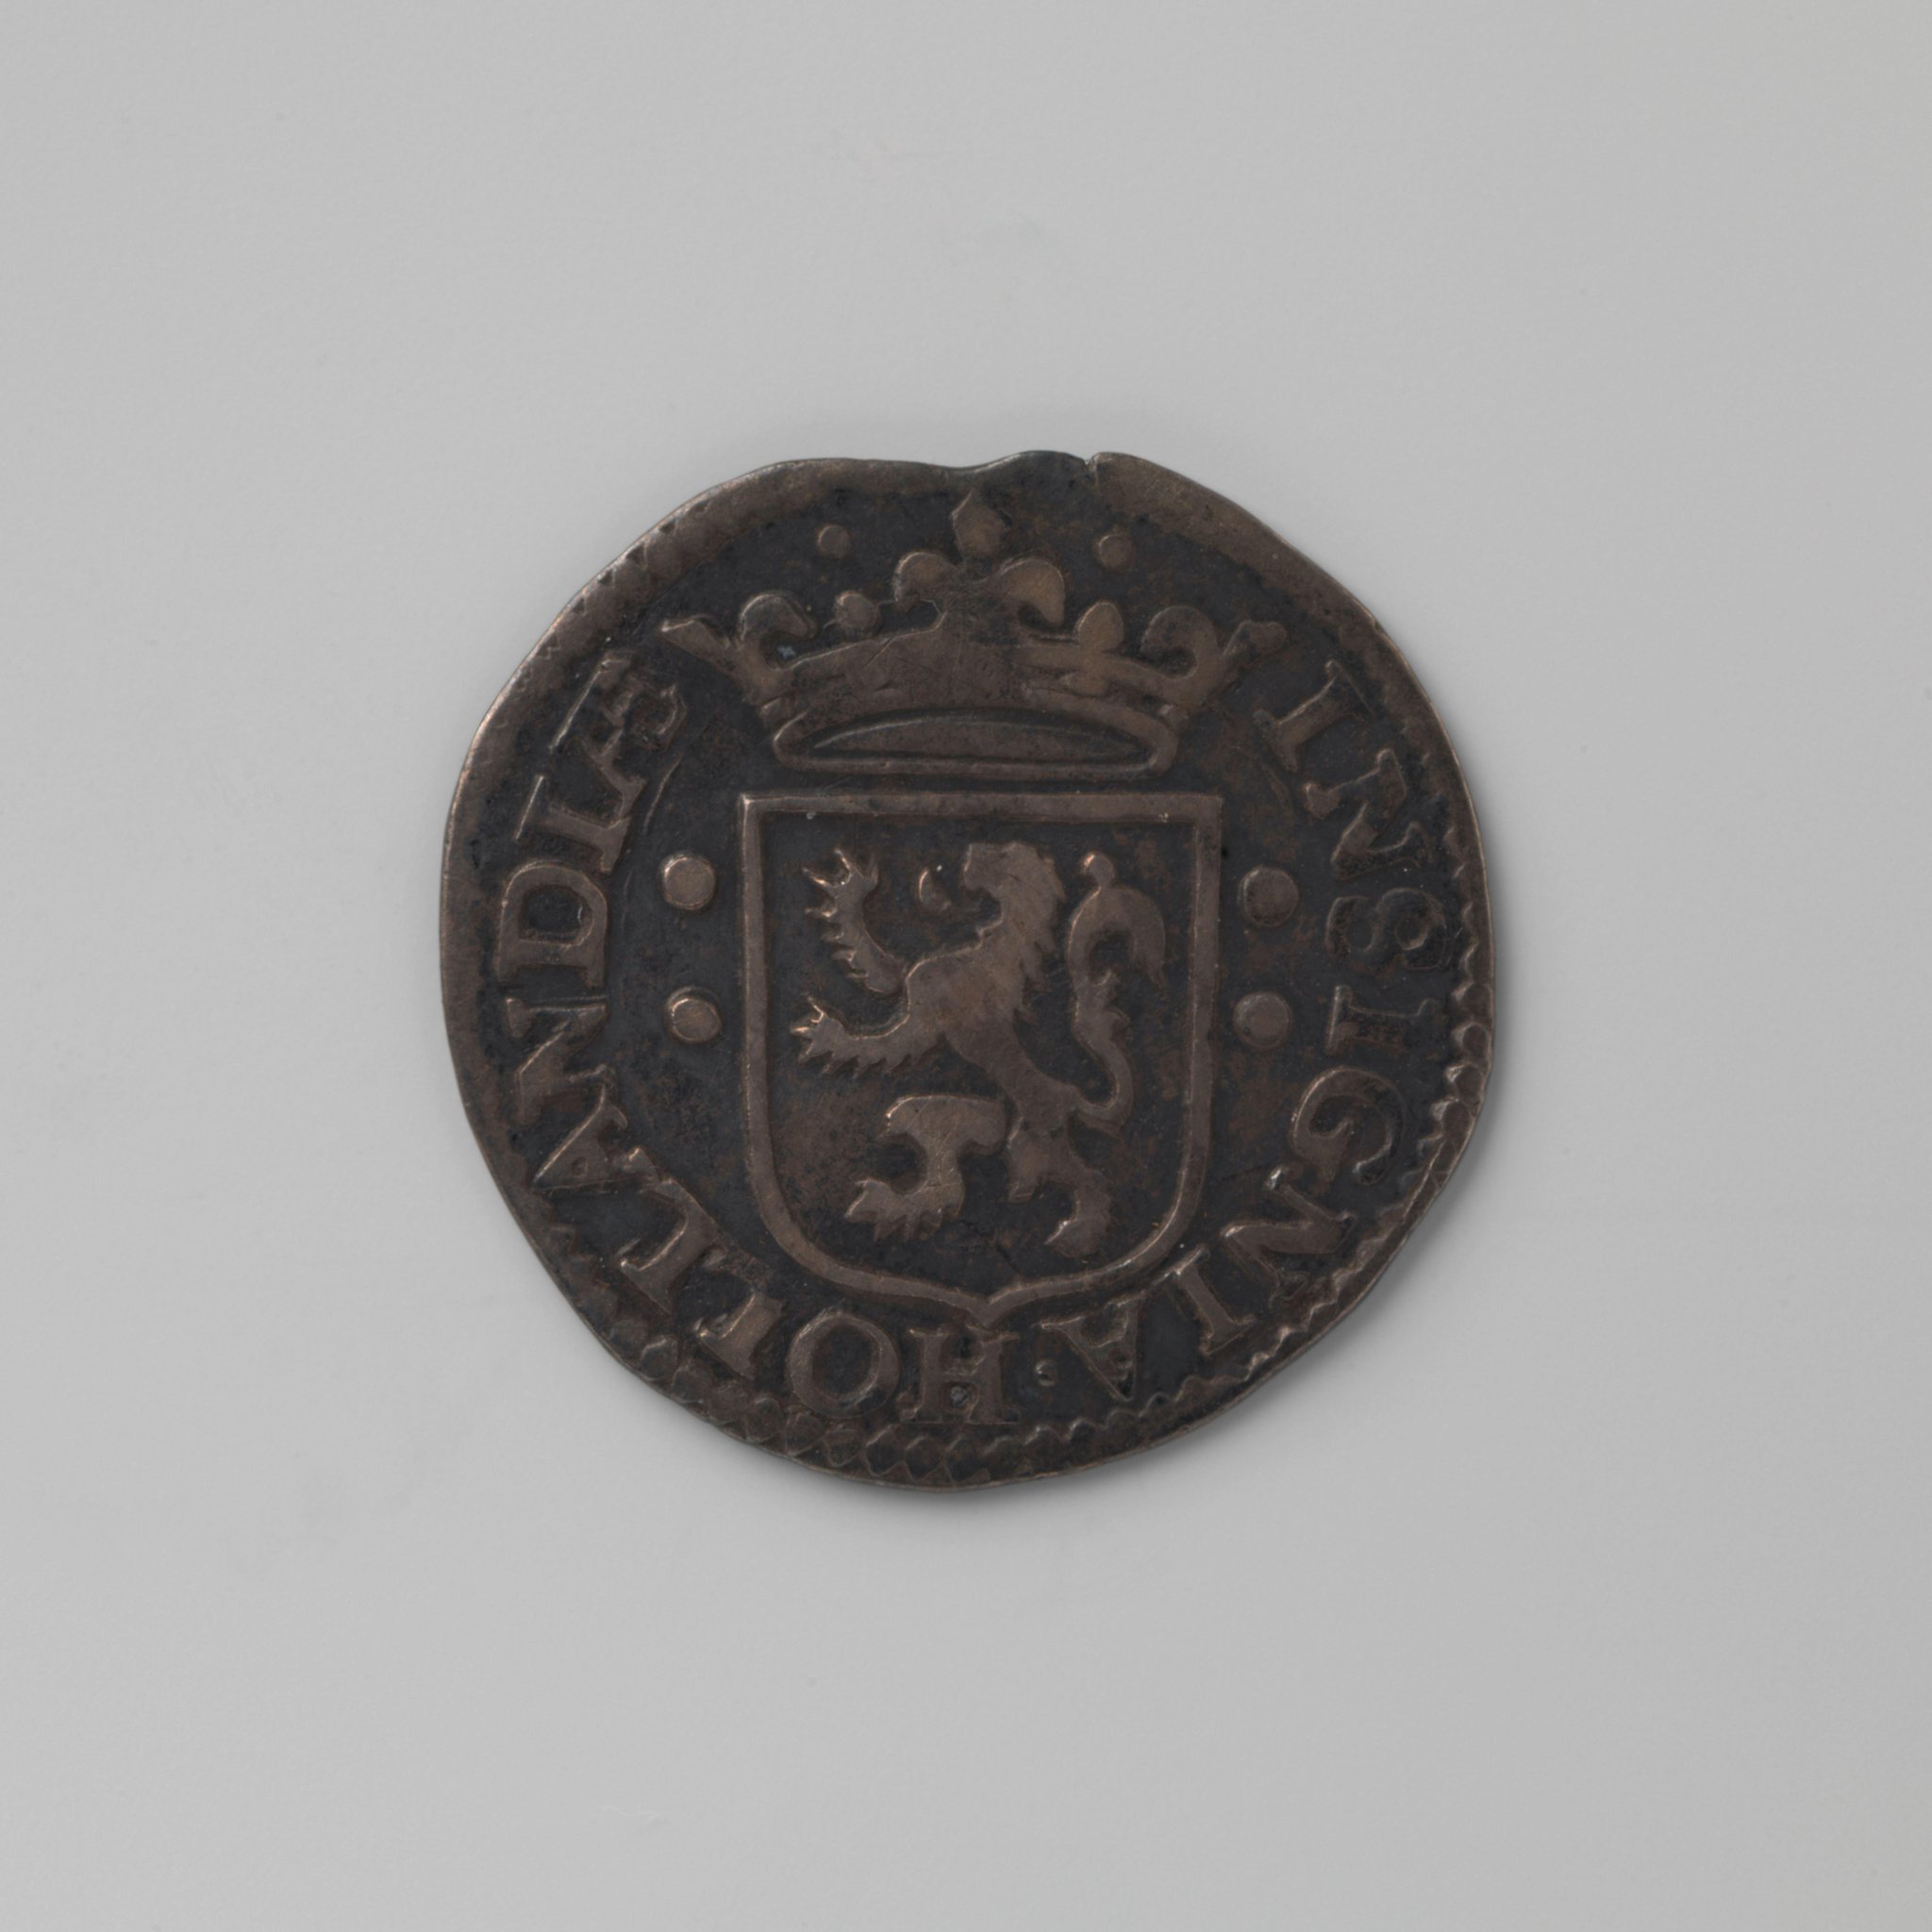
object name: coin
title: Verenigde Amsterdamse Compagnie, ½ reaal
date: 1601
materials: silver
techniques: striking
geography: dordrecht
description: Zilveren munt. Voorzijde: tussen waarde-aanduiding gekroond wapenschild van Holland. Keerzijde: door twee leeuwen gehouden wapenschild van Amsterdam, geen omschrift.